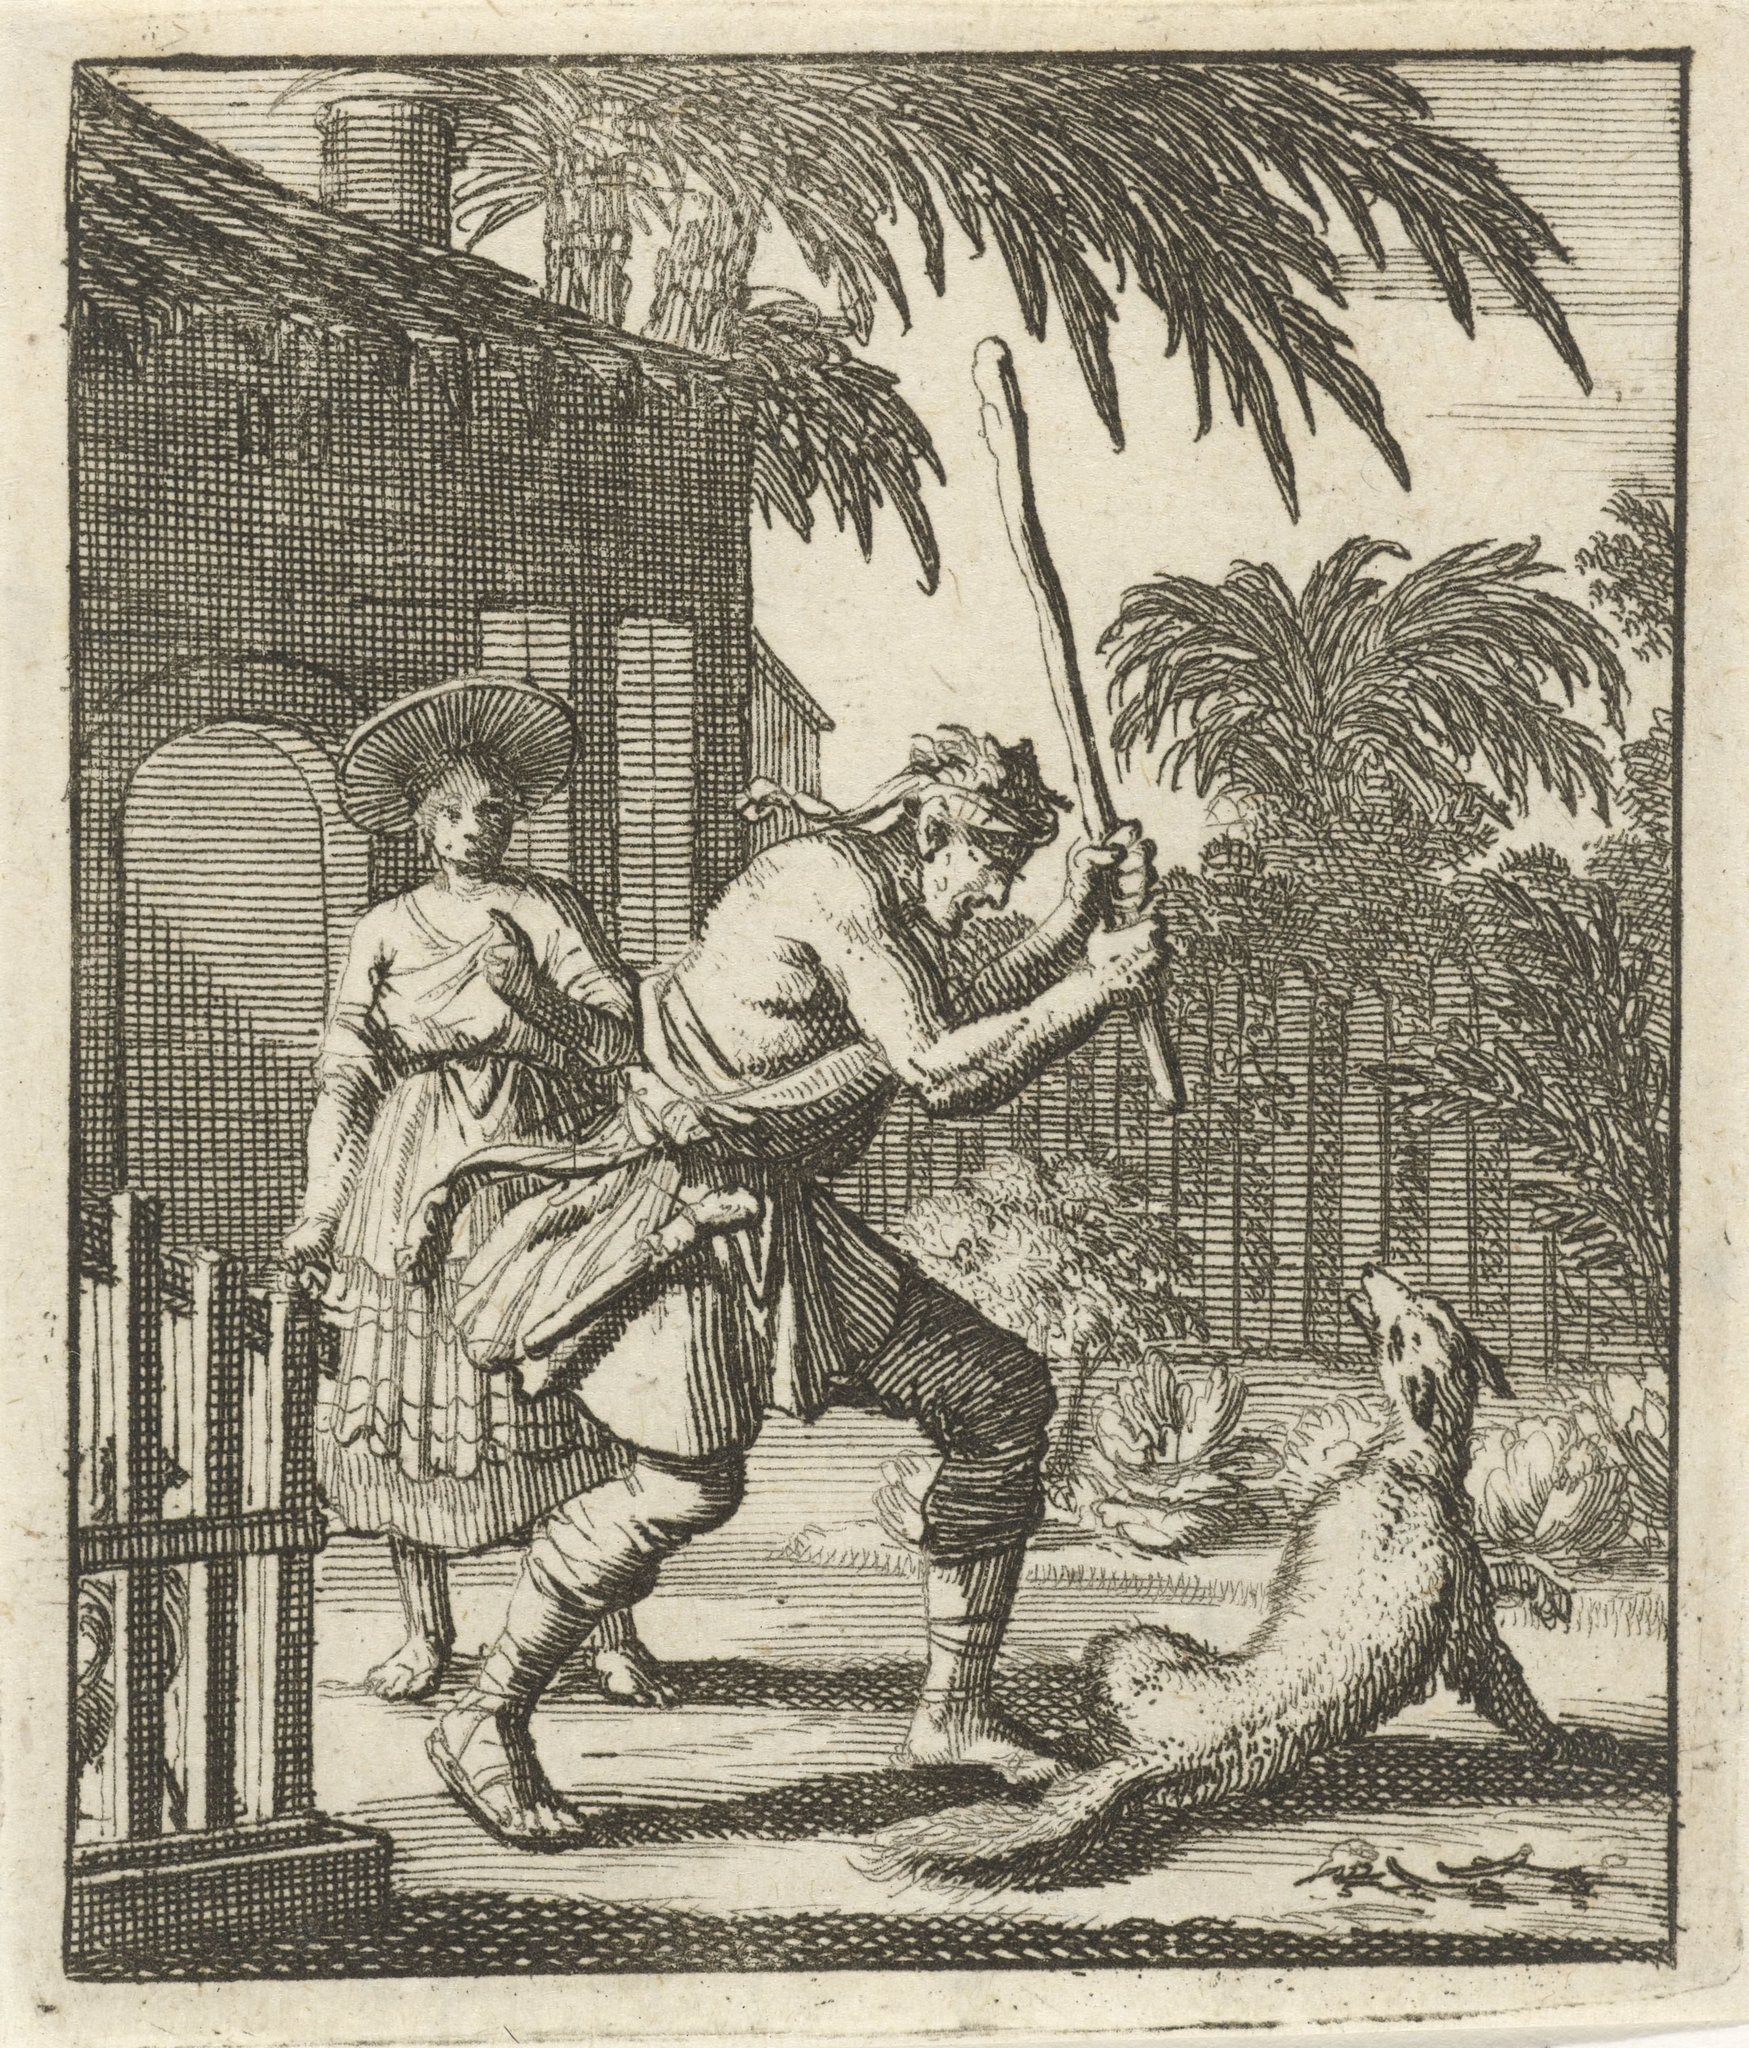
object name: book illustration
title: Vos door een man met een stok gedood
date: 1693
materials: paper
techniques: etching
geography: amsterdam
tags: man killing animal, beasts of prey, predatory animals: fox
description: Illustratie uit: Duĳkerius, Johannes. Voorbeeldzels der oude wyzen. Waar in (...) de menschelijke hartstogten (...) behandeld worden. Amsterdam: Aart Wolsgrein, 1693, p. 551.